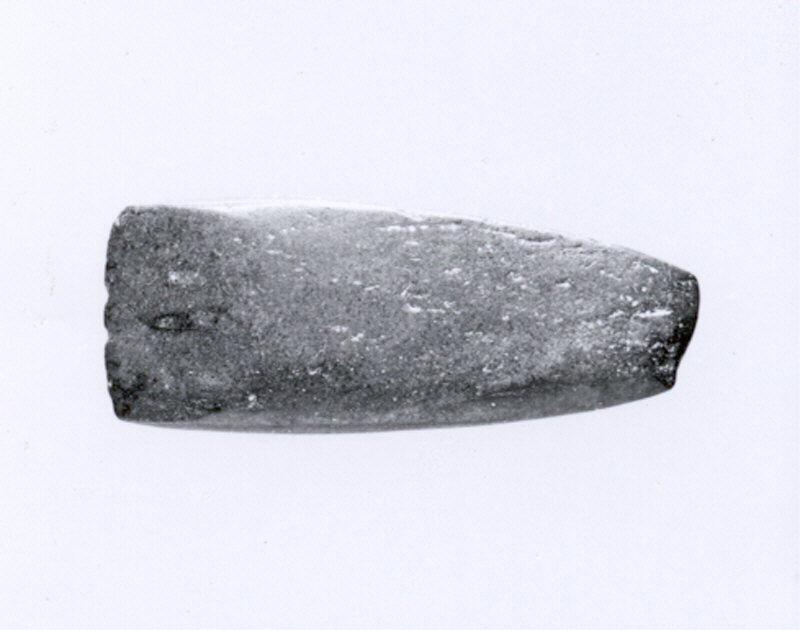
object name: chisel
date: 3000-2001 BCE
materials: stone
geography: anatolia